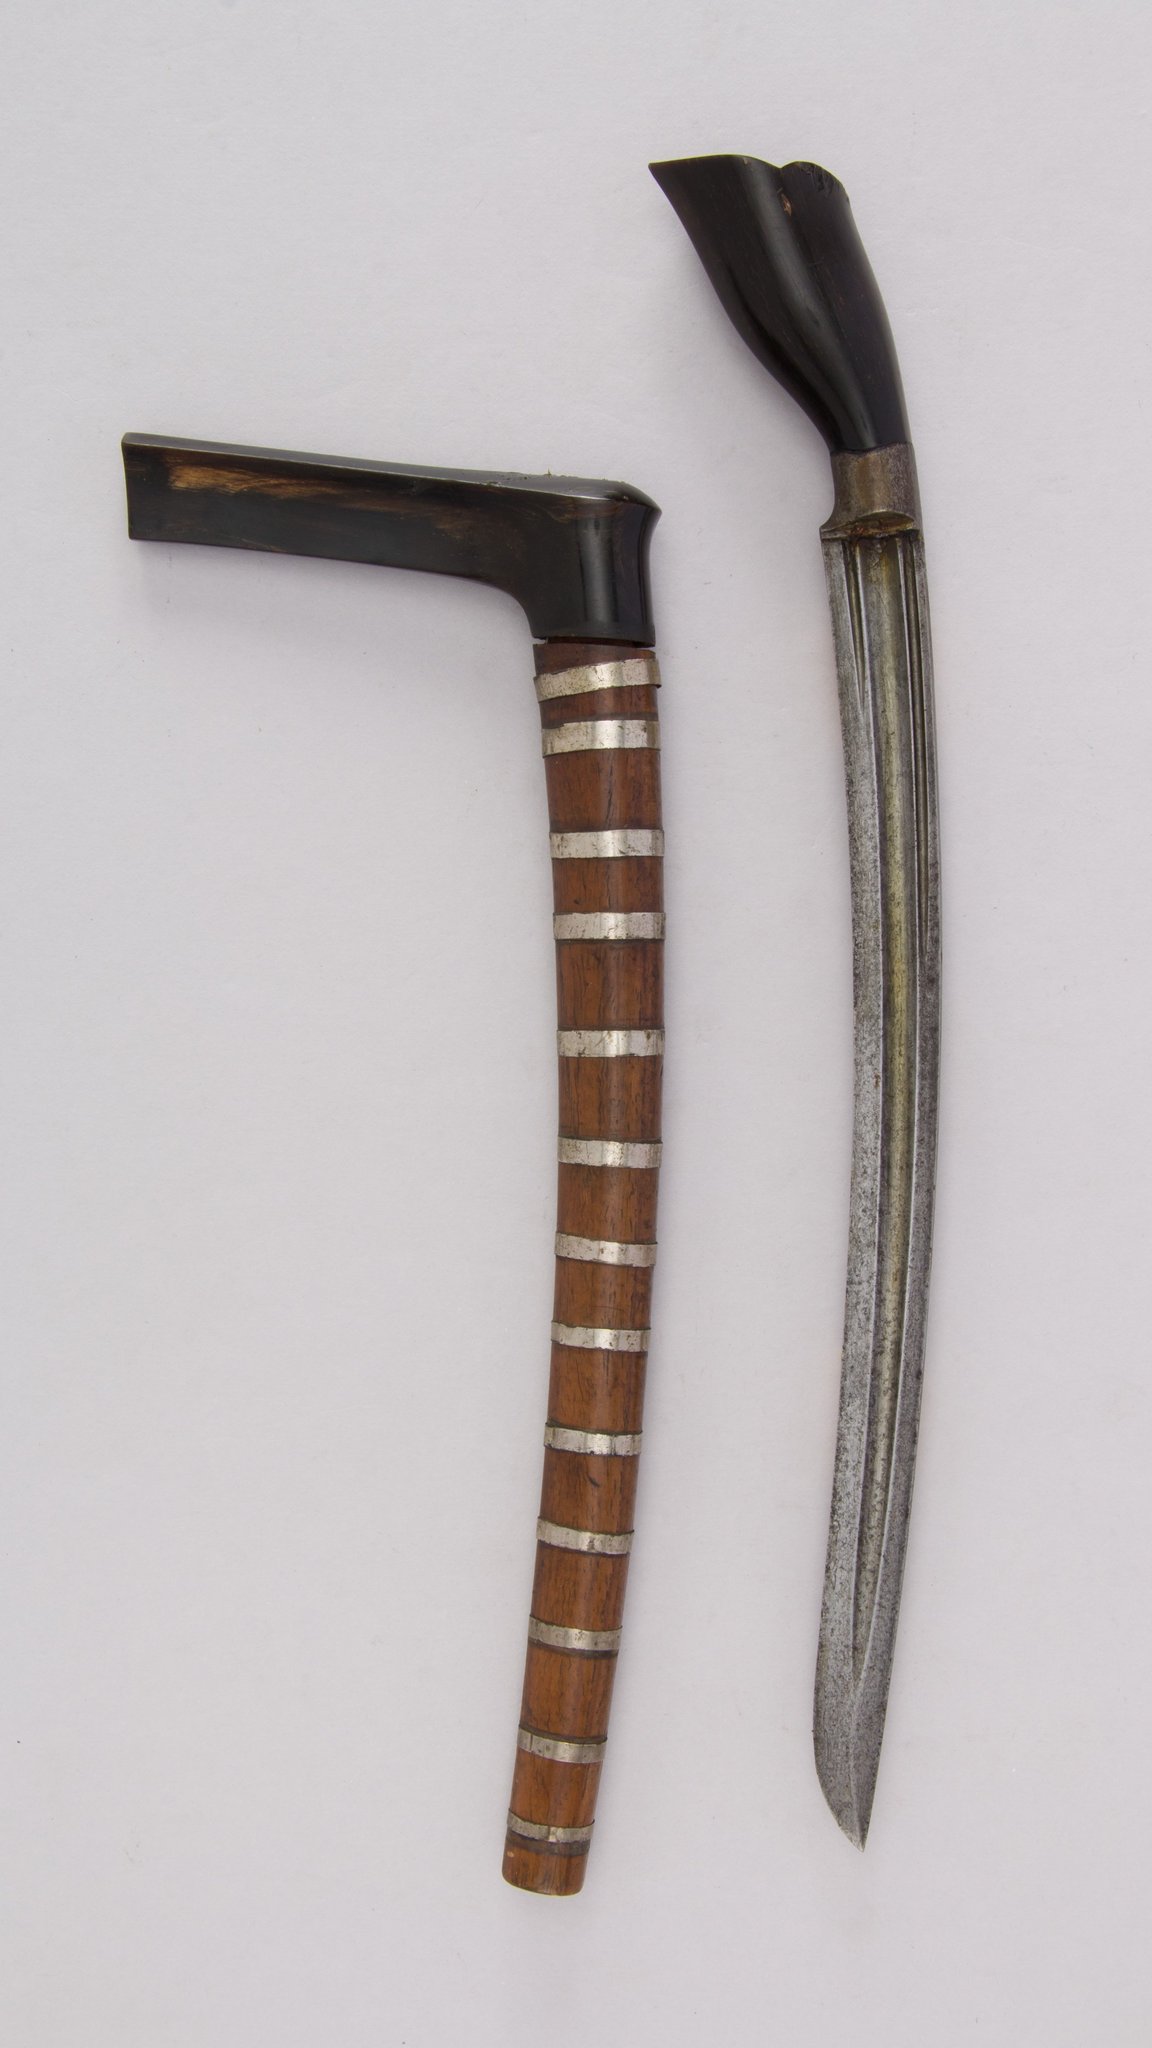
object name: knife bade bade with sheath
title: Knife (Bade-bade) with Sheath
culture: malayan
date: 1701-1900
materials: horn, silver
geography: malaysia